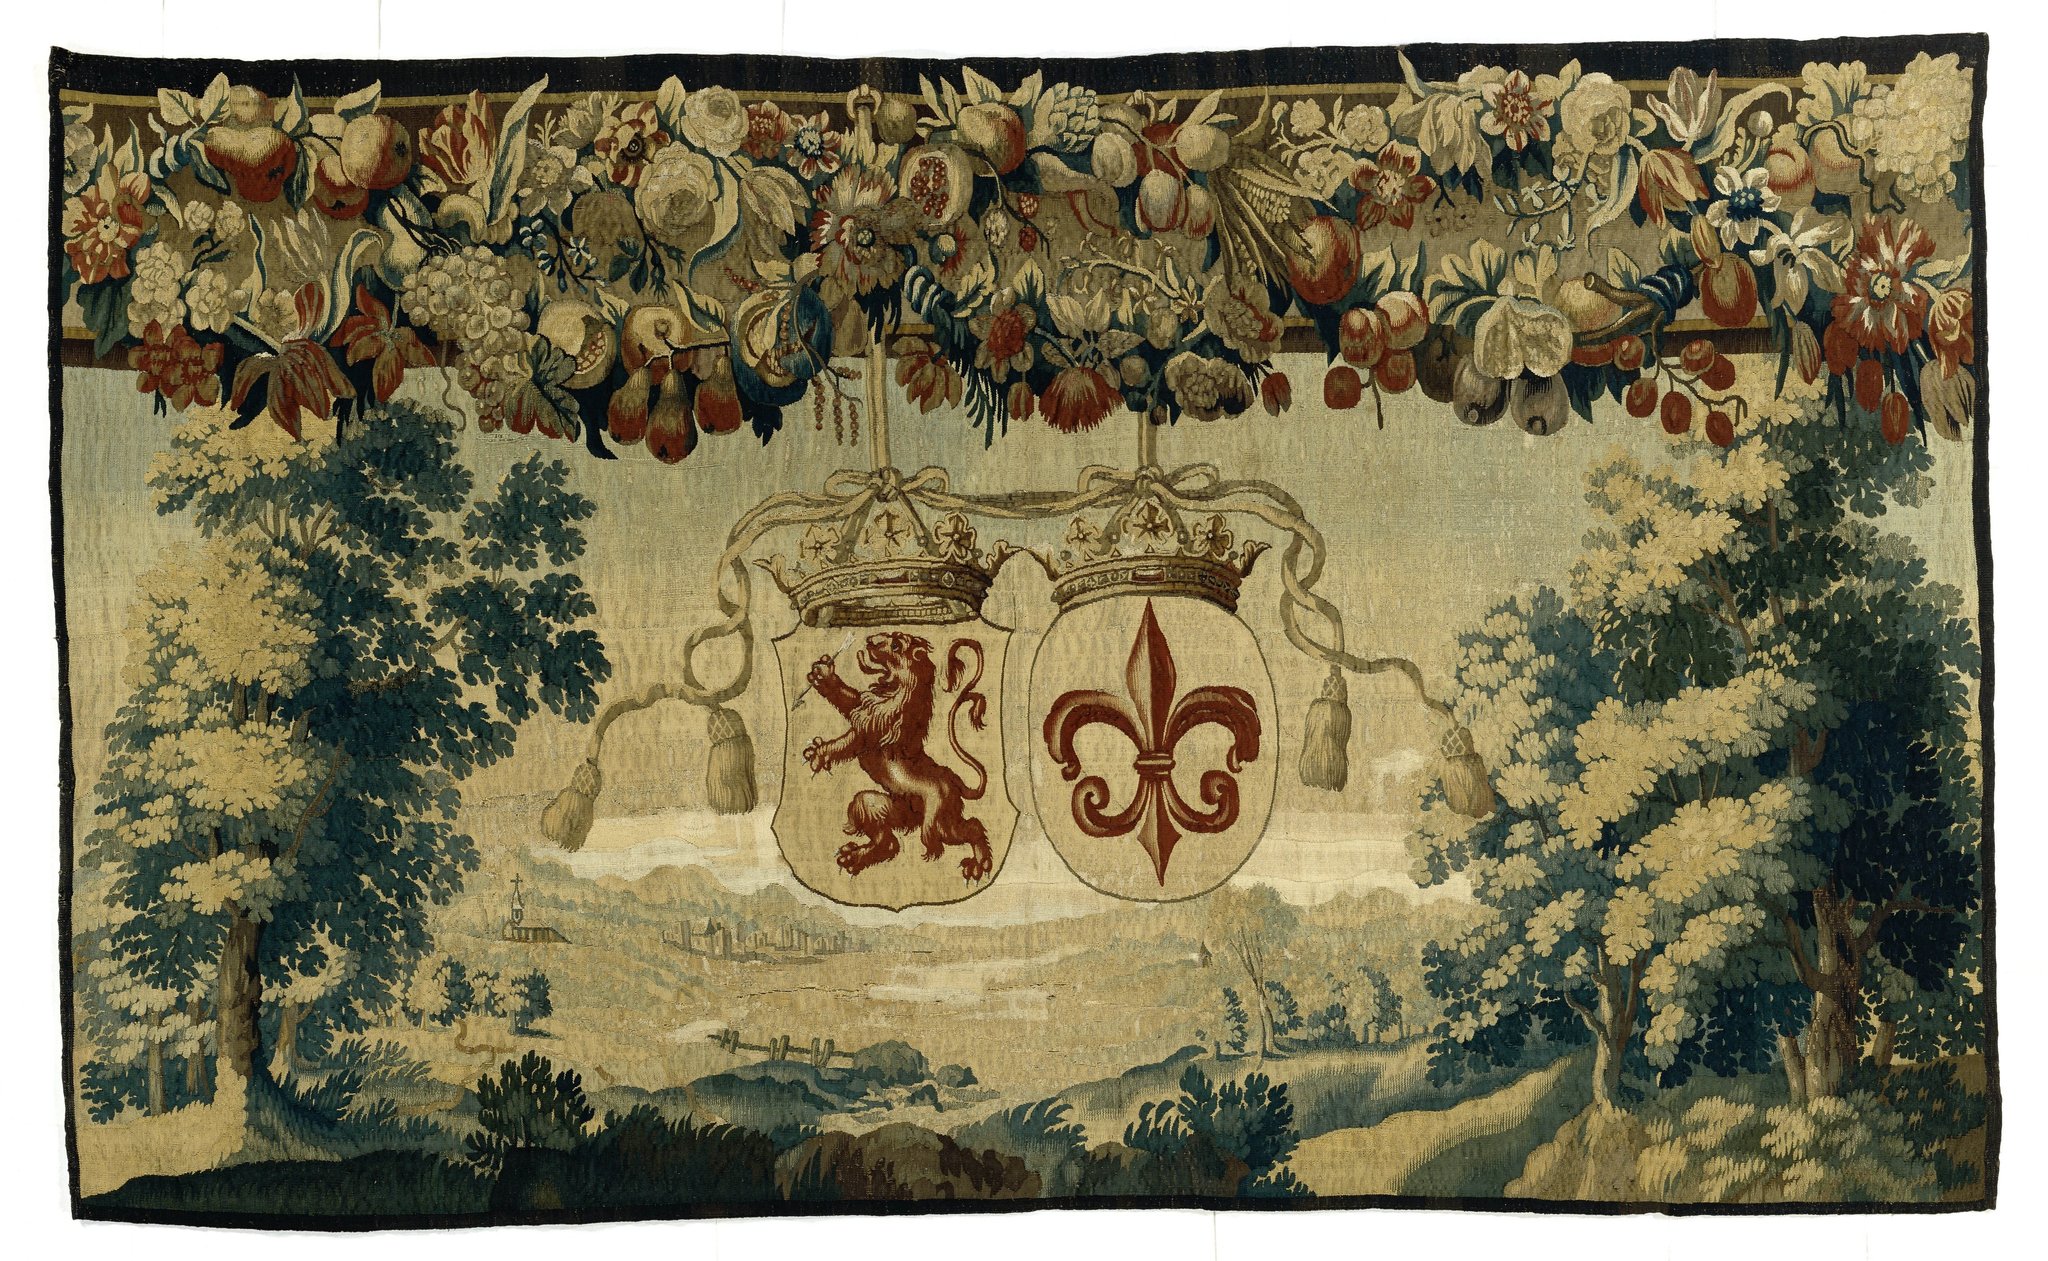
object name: tapestry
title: Landschap met de wapens van Ortt en Pergens (fragment ?)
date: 1672-1700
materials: silk, wool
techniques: tapestry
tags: johan ortt, anna pergens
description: Part of a wool and silk tapestry, showing the combined arms of Ortt-Pergens. Northern Netherlands, 4th quarter 17th century.